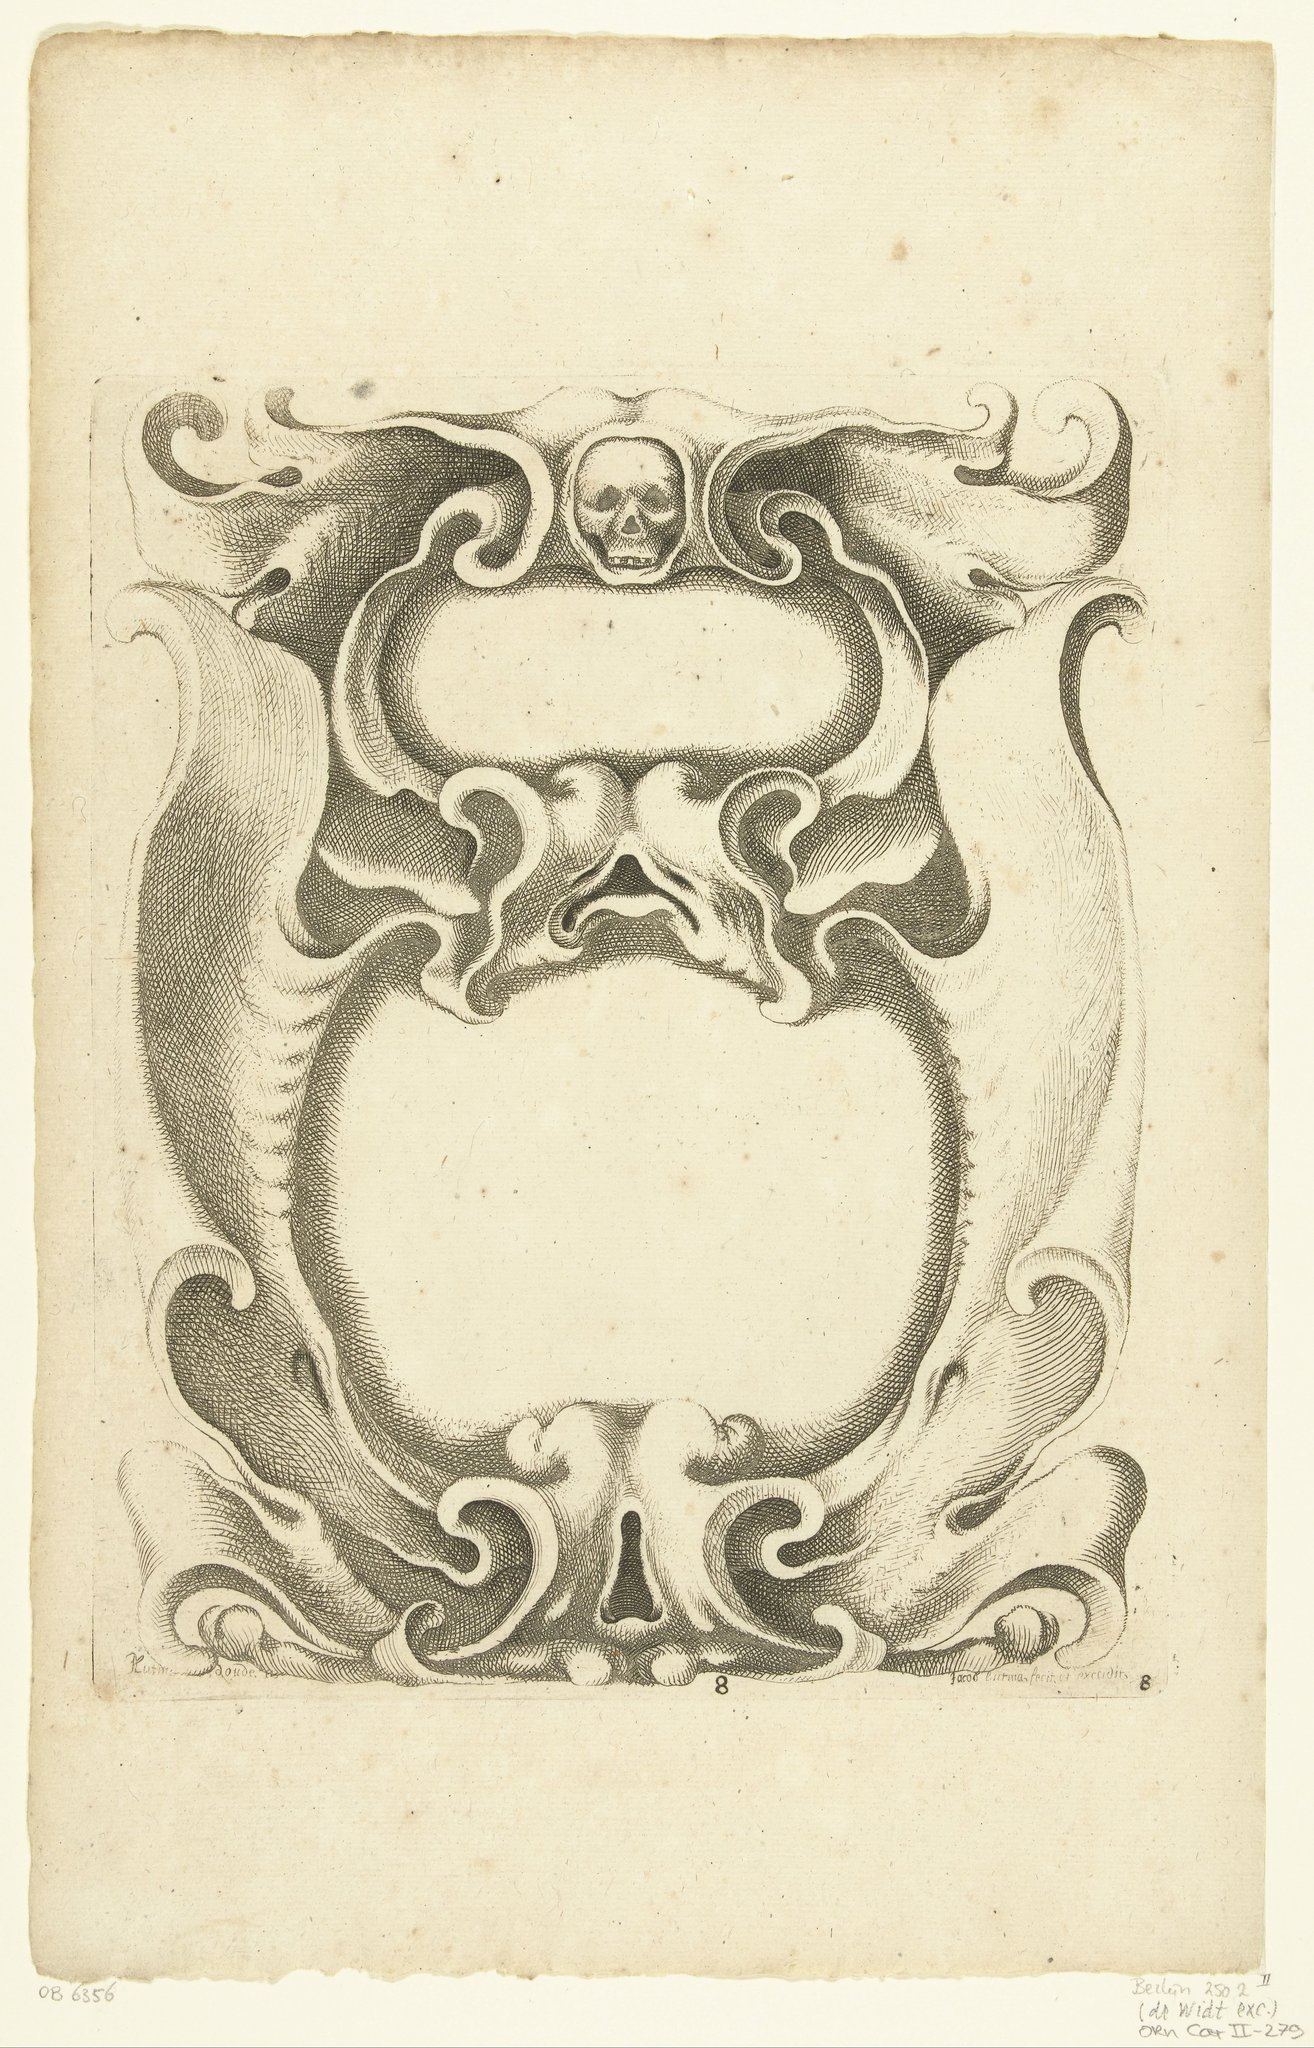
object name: ornament print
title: Festivitates, Aurifabris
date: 1654-1678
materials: paper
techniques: etching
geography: amsterdam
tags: (human) skull, ornament ~ cartouche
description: Cartouche met een klein en groot compartiment, in de middelste en onderste rand is een masker verwerkt. Prent uit tweede editie van serie.